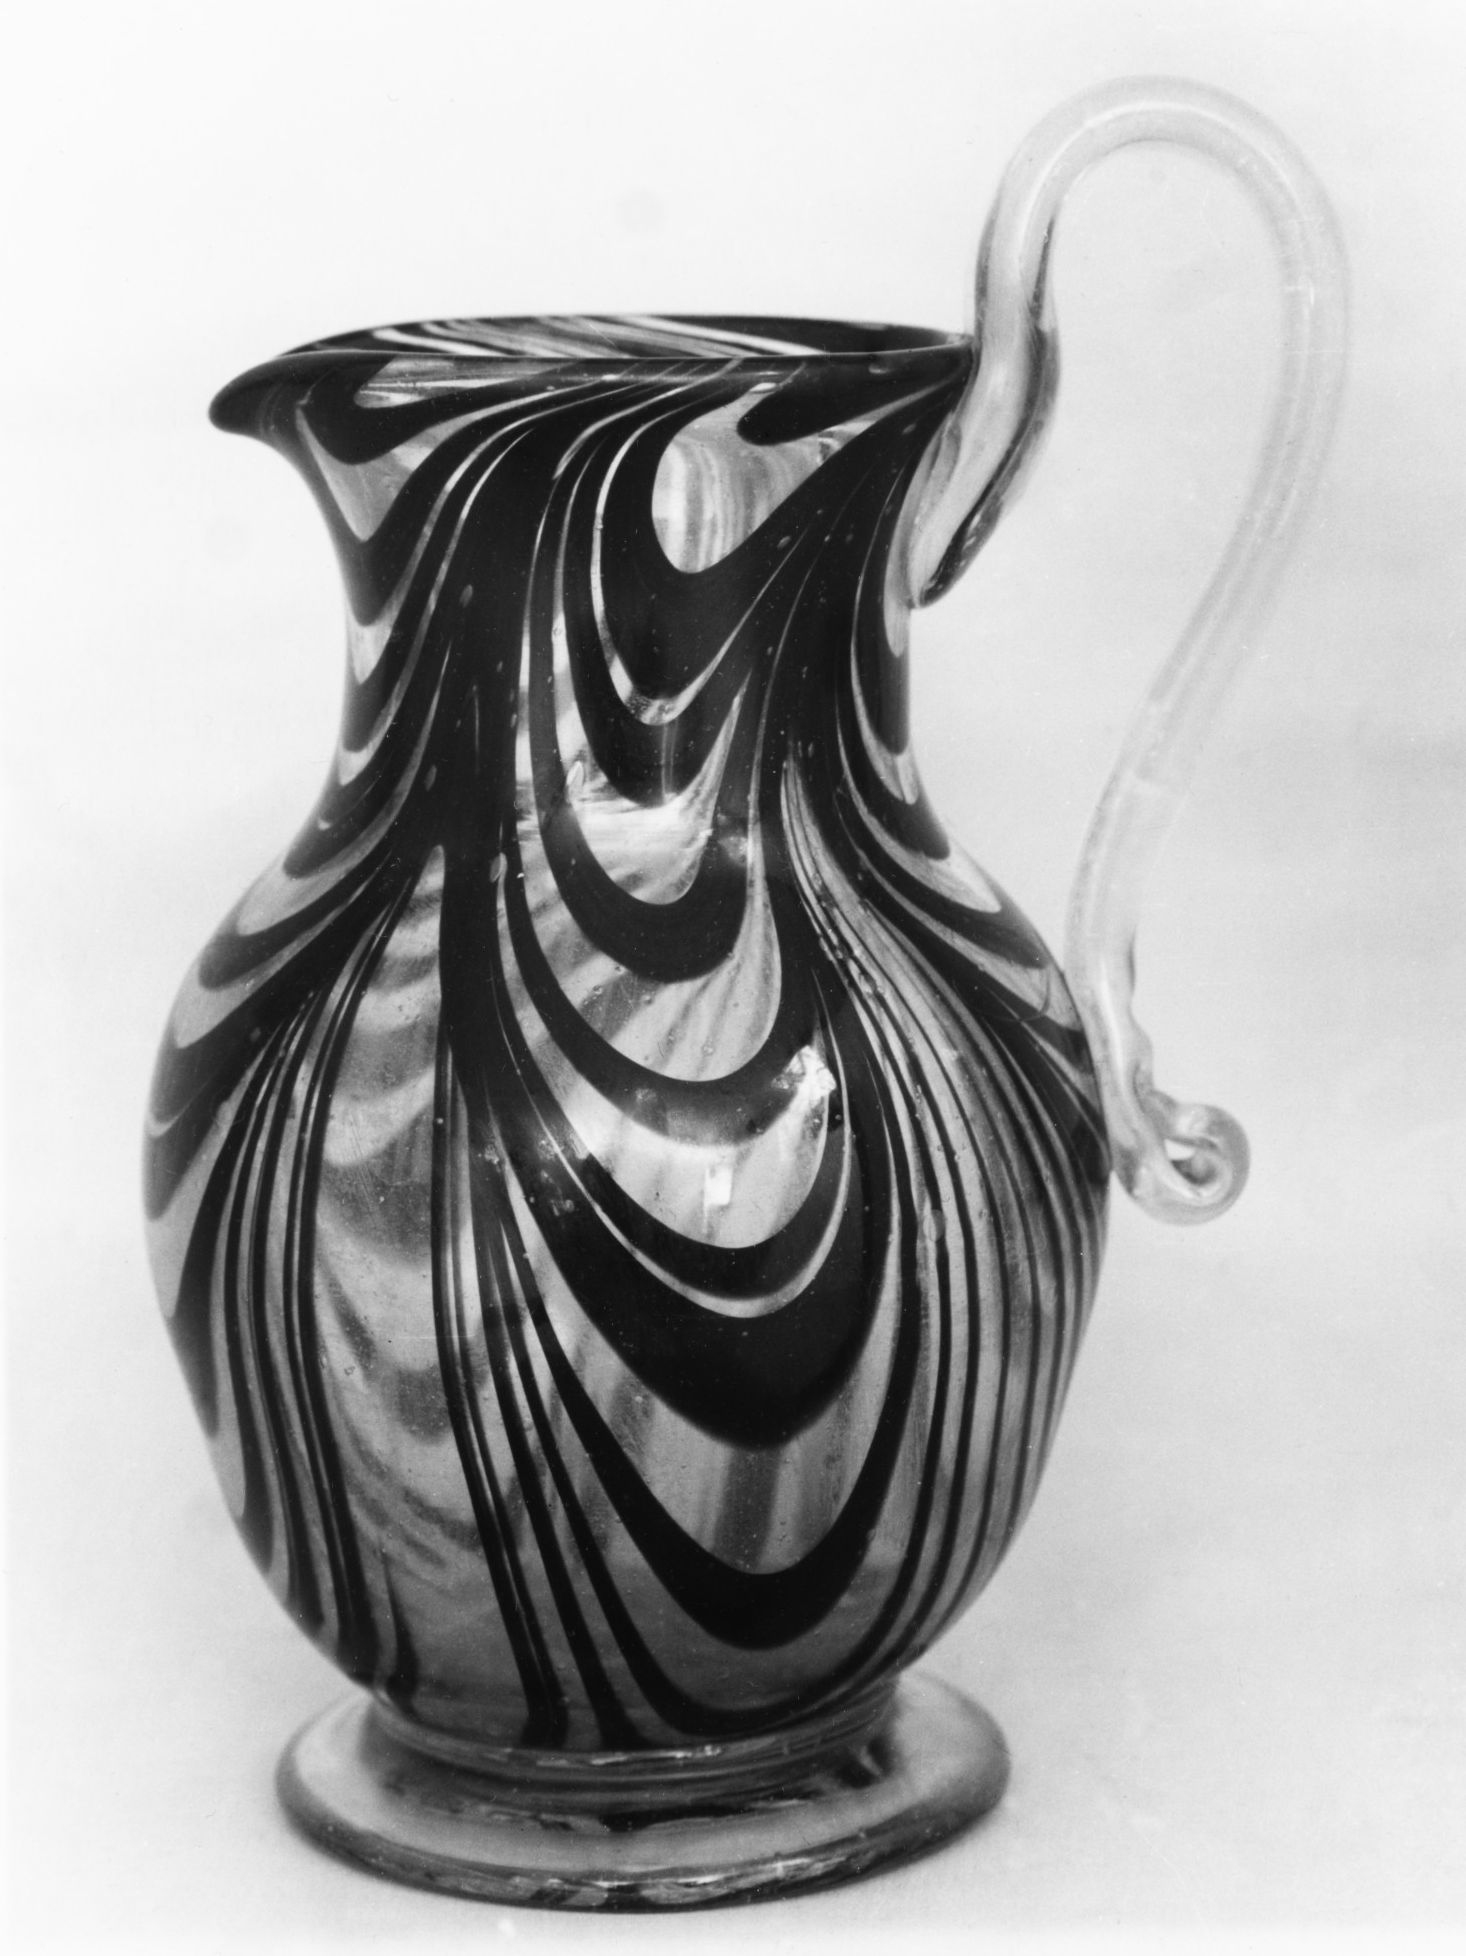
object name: pitcher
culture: american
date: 1860-1880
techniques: glassblowing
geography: united states